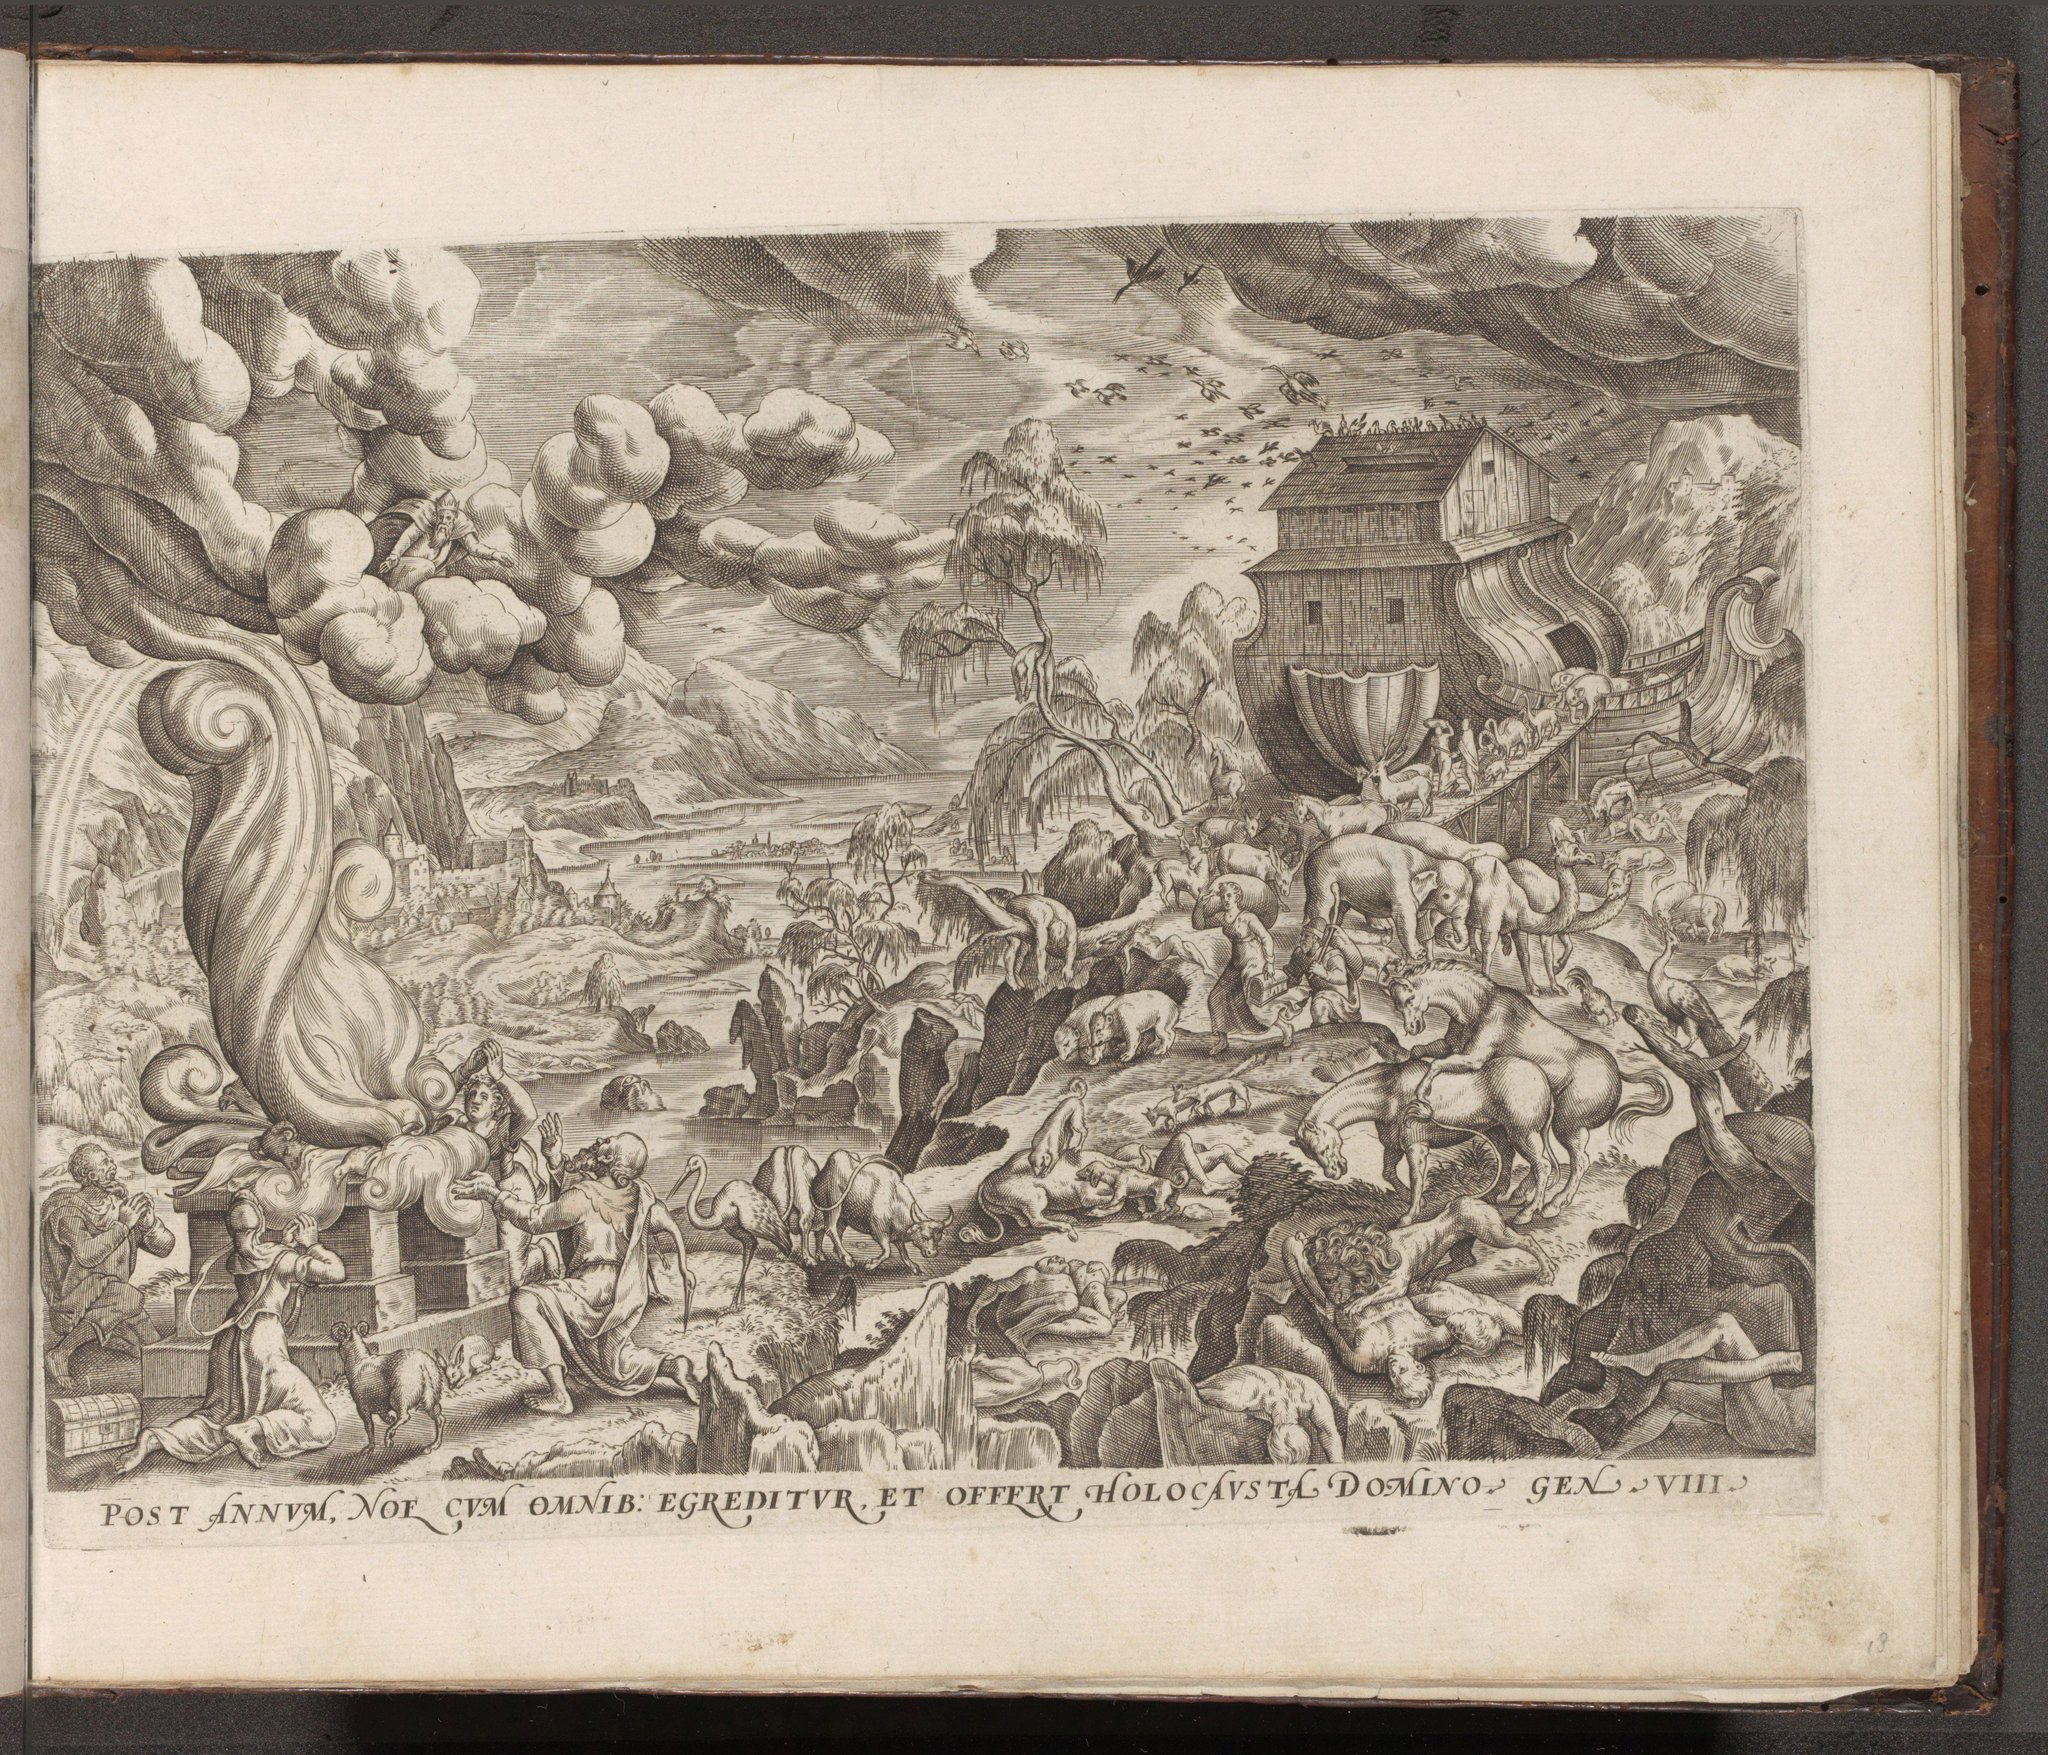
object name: album leaf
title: Dieren verlaten de ark en Noach dankt God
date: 1579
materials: paper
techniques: engraving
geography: antwerp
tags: noah's sacrifice; various animals are offered, possibly a lamb, a dove and a ram (often combined with the rainbow of the covenant), noah, his family and the animals leave the ark (sometimes combined with the rainbow of the covenant)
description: Noach en zijn familie brengen een offer aan God. Op een wolk verschijnt God de Vader. Rechts de ark, waaruit de dieren over een loopbrug aan land gaan. Op de grond liggen verdronken mensen en dieren. Onderaan een verwijzing naar de Bijbeltekst in Gen. 8 in het Latijn. Prent maakt deel uit van een album.